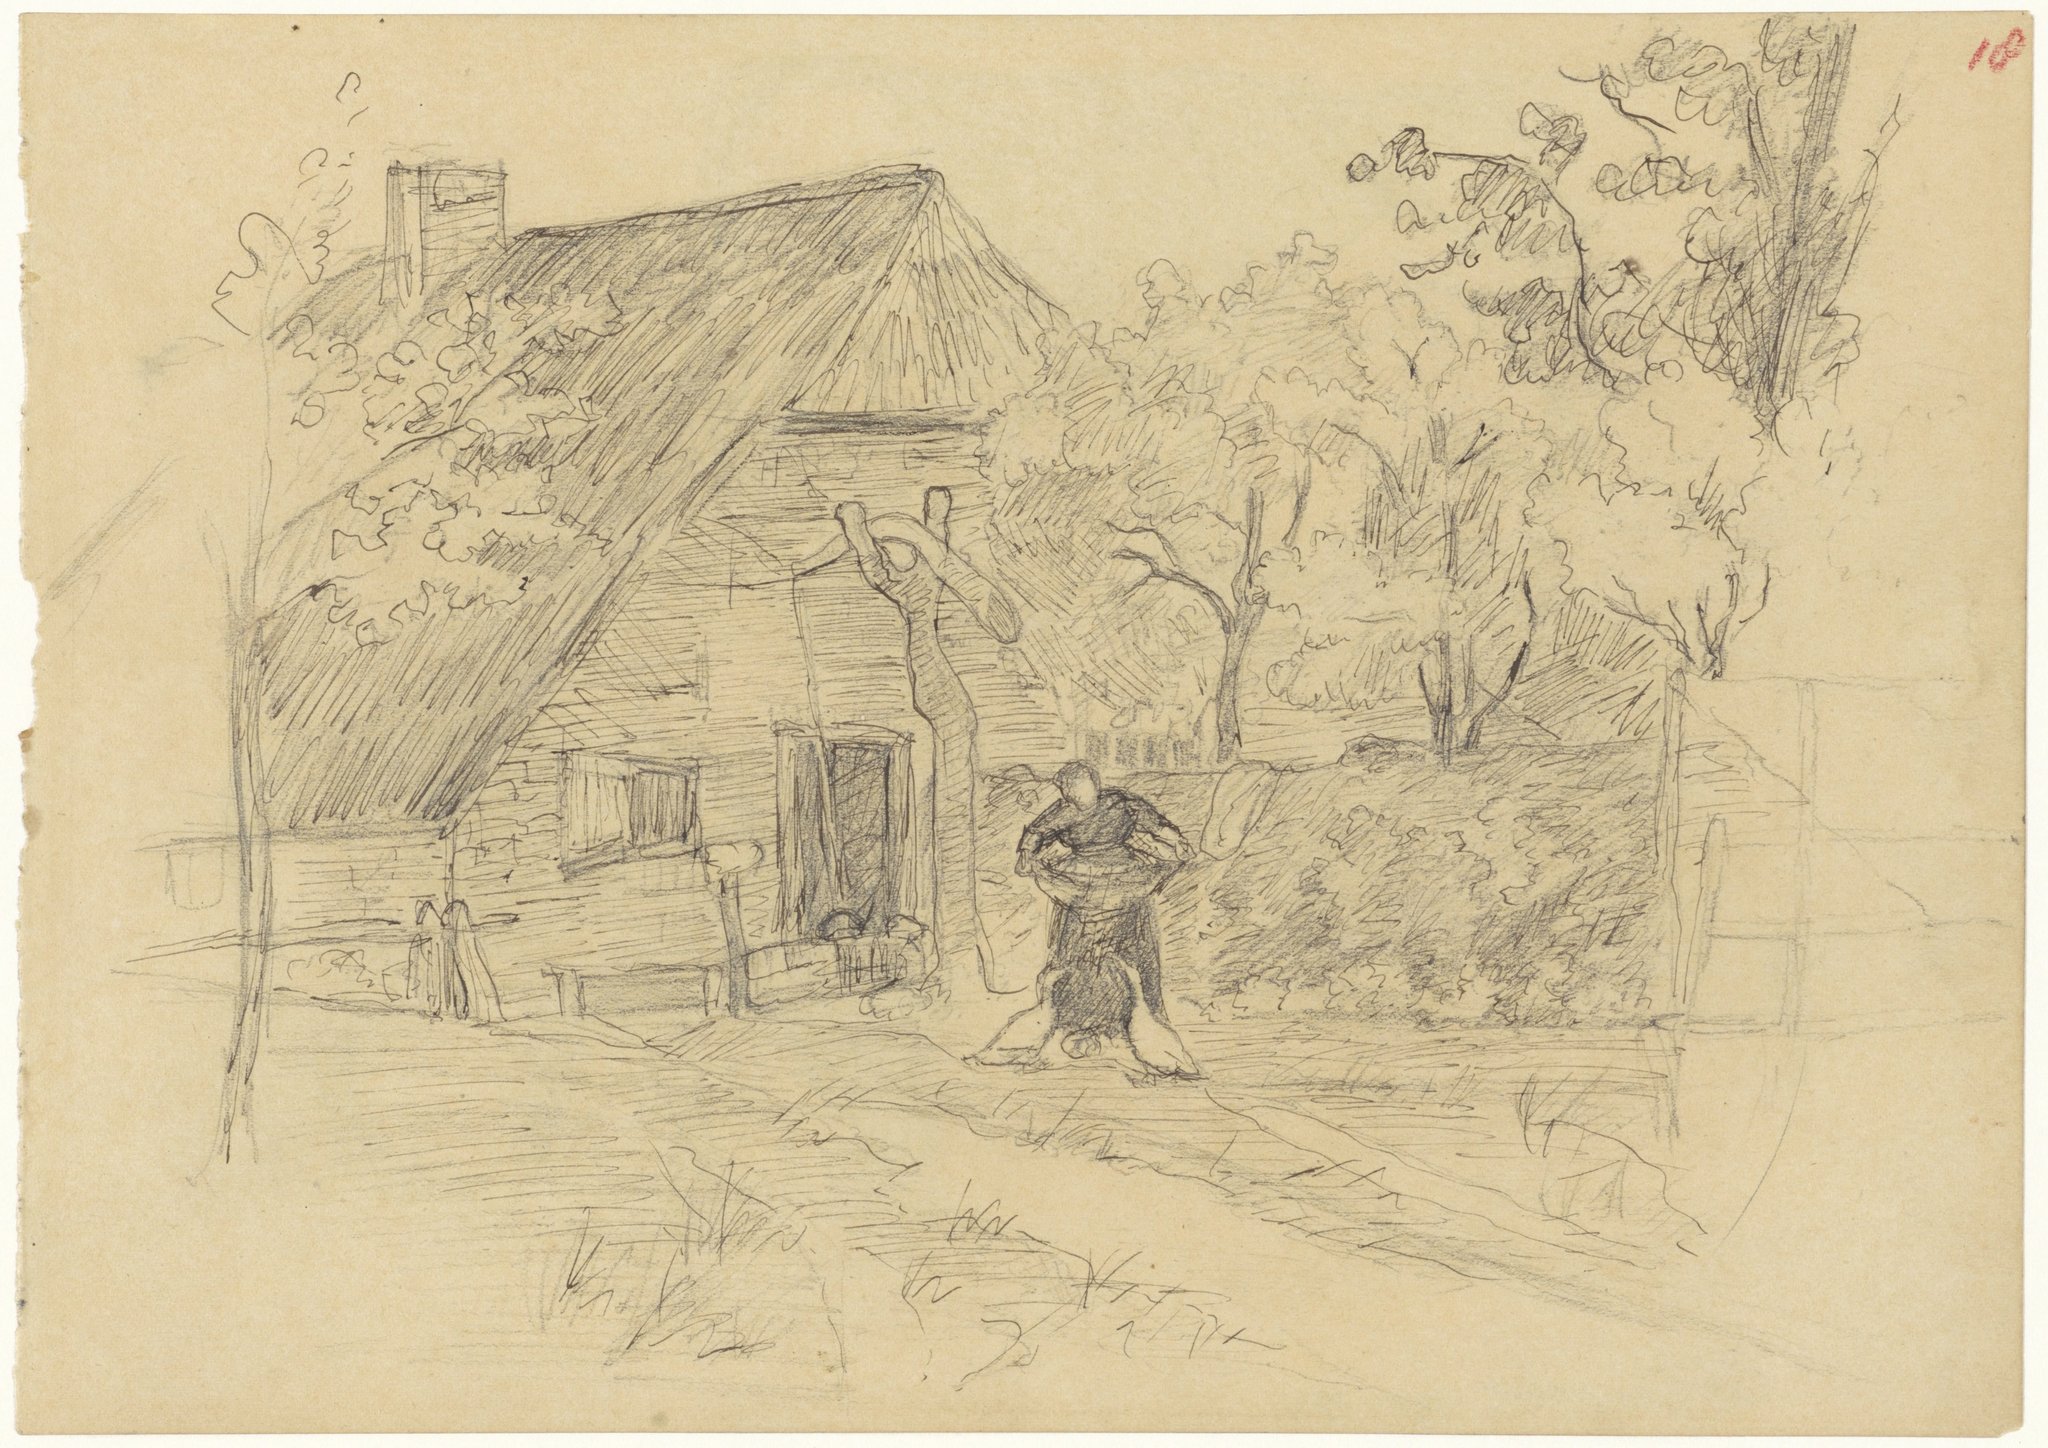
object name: drawing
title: Erf met ganzen voerende vrouw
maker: jozef israëls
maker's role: draughtsman, painter, print maker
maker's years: 1824-1911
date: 1834-1911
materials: ink, paper, pencil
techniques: pen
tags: domestic waterbirds, farm (building)